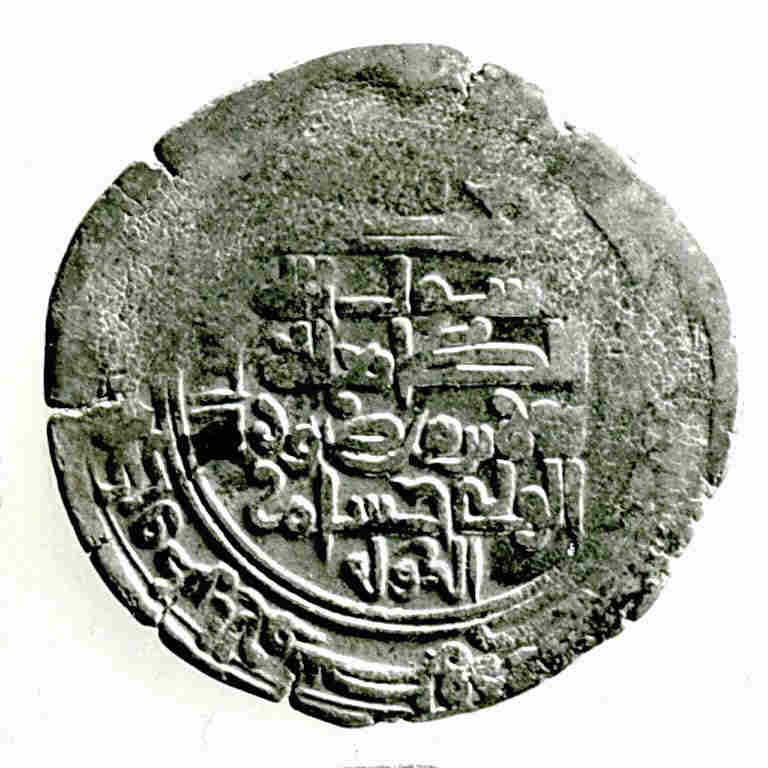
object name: coin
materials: silver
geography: iran